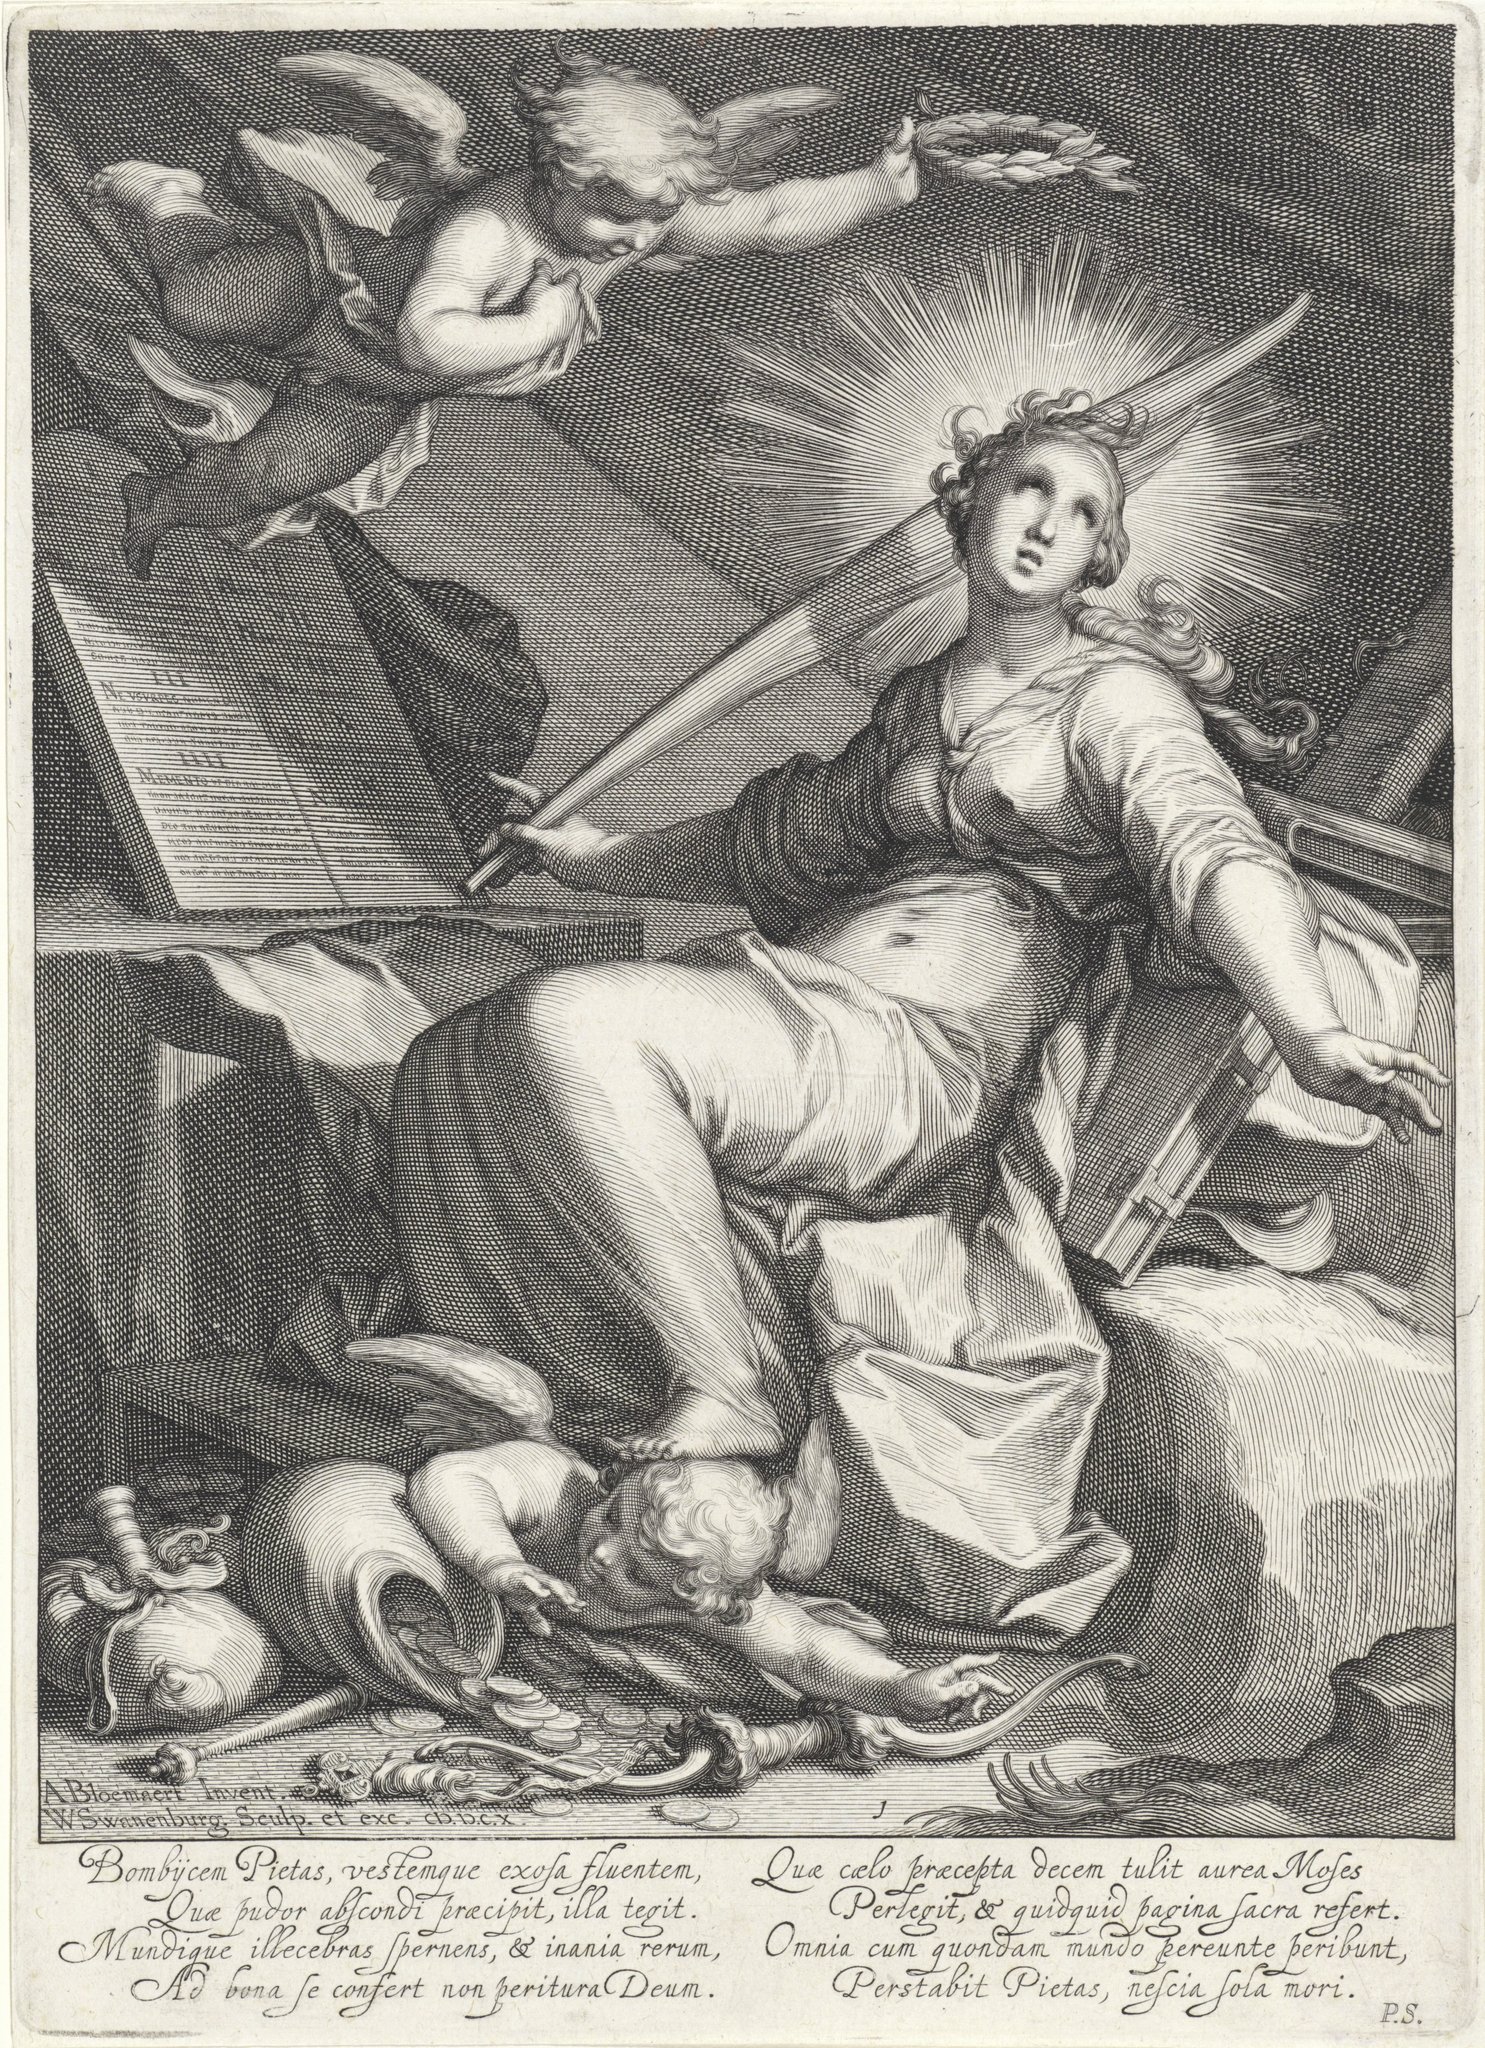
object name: print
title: Vroomheid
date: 1610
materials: paper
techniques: engraving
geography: utrecht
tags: devotion, piety; 'divotione' (ripa), faith, 'fides'; 'fede', 'fede catholica', 'fede christiana', 'fede christiana catholica' (ripa) ~ one of the three theological virtues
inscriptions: collector's mark: Lugt 240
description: Een vrouw zit als personificatie van vroomheid bij twee stenen tafelen met daarop de tien geboden. Rond haar hoofd is een stralenkrans te zien en in haar rechterhand heeft ze een palmtak. Achter haar liggen enkele boeken. Een putto kroont haar met een lauwerkrans en met haar voet vertrapt ze een andere putto die bij een zak met geld ligt. Onder de voorstelling bevindt zich een achtregelig, Latijnse tekst met een beschrijving van de voorstelling en van de deugd in het algemeen.